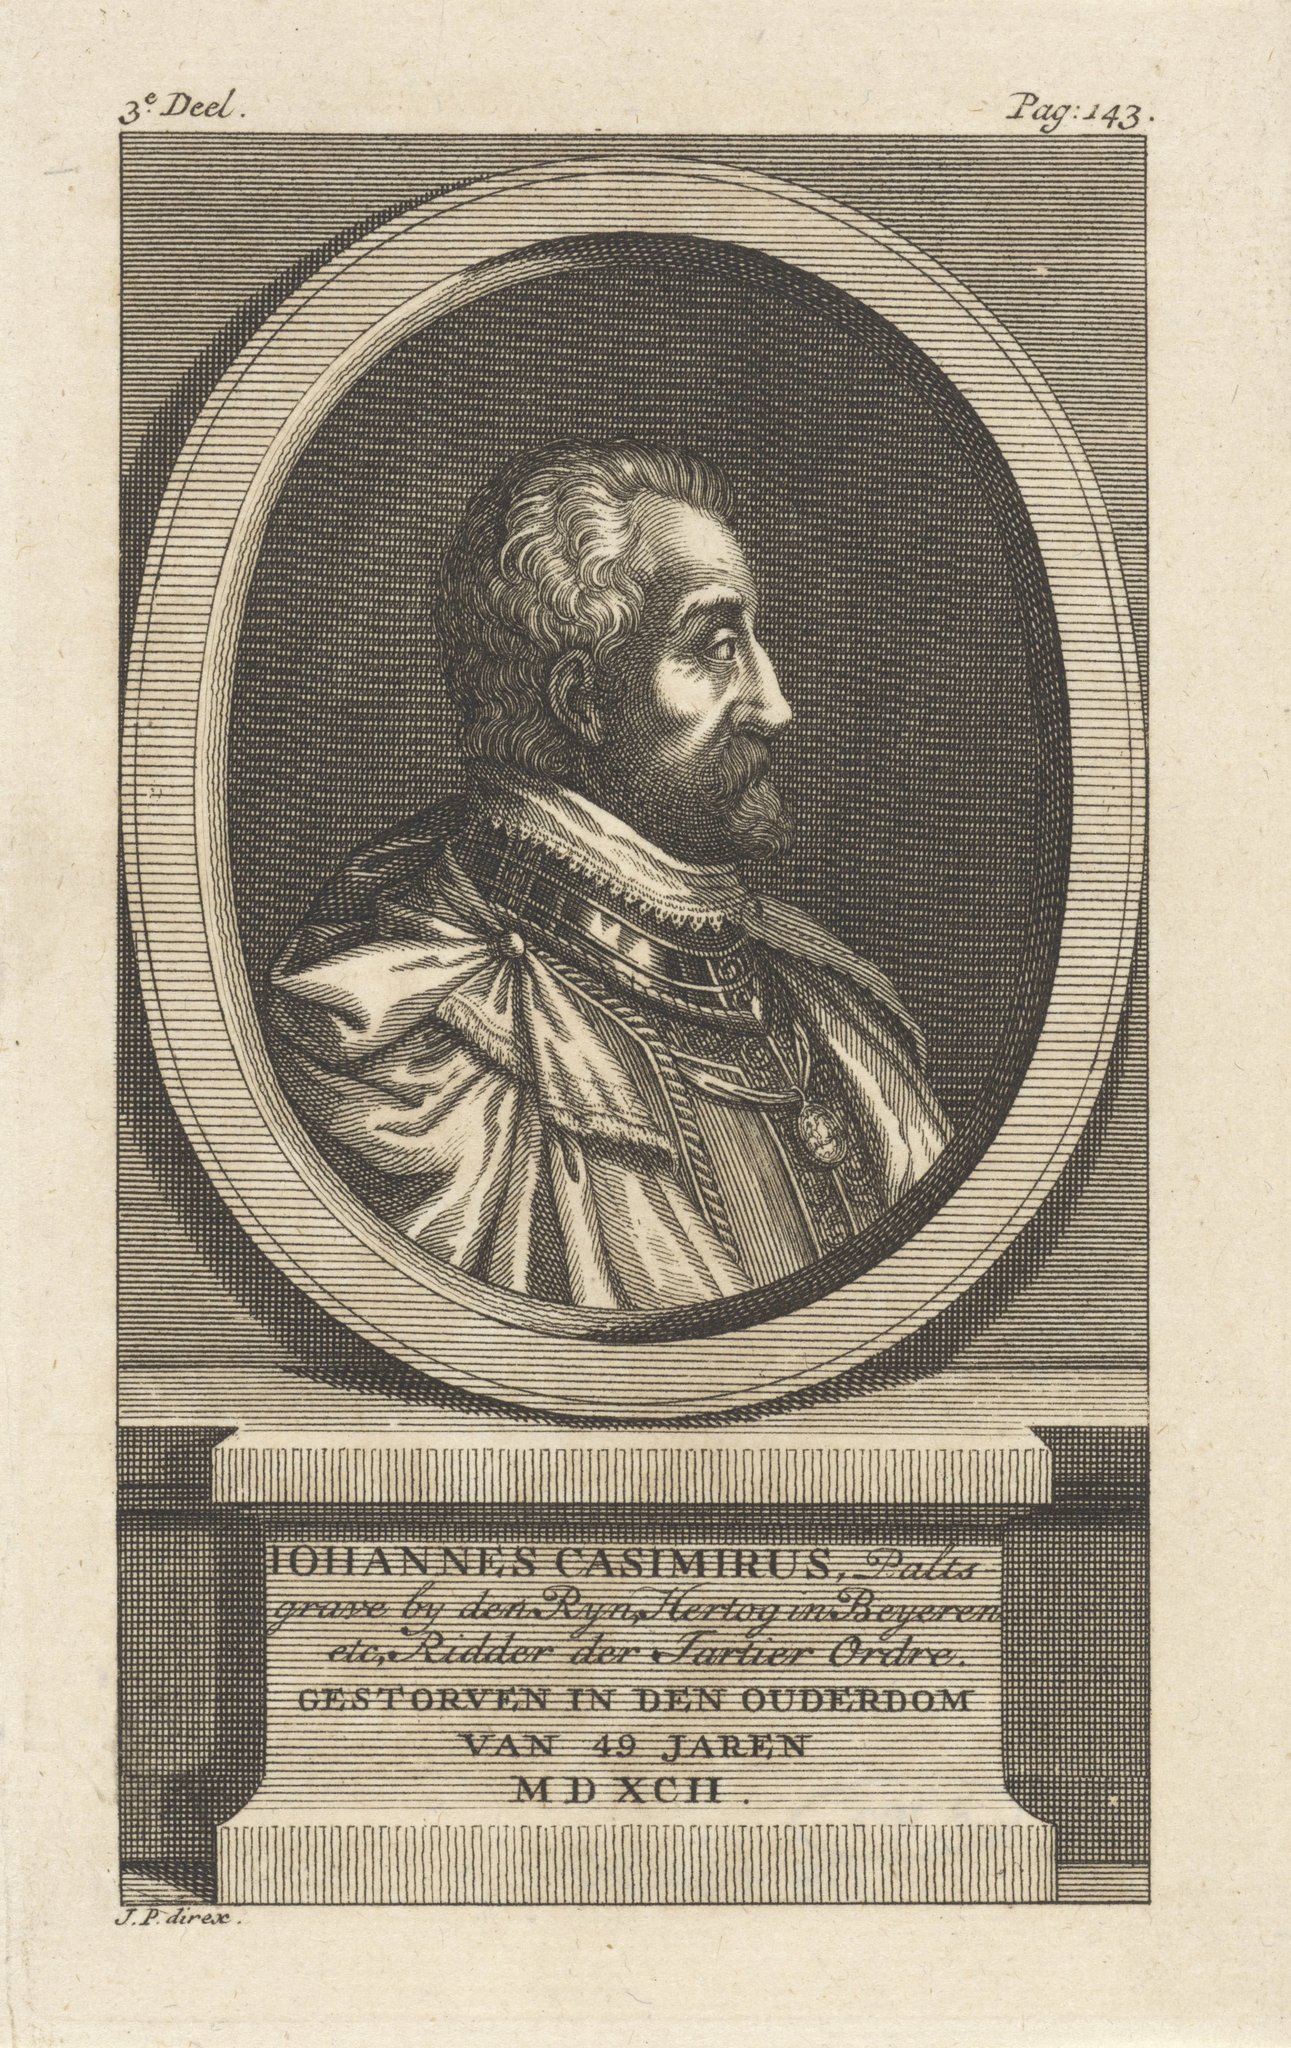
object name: print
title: Portret van Johan Casimir, paltsgraaf aan de Rijn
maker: jan punt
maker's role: draughtsman, print maker, publisher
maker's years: 1711-1779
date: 1750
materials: paper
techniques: engraving, etching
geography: northern netherlands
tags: knighthood order, armour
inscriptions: collector's mark: Lugt 2228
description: Illustratie uit: Meteren, Emanuel van. Historie van de oorlogen en geschiedenissen der Nederlanderen, en der zelver naburen: beginnende met den jare 1315, en eindigende met den jare 1611, deel III, p. 143. Gorinchem/Breda: Nicolaas Goetzee/Willem Goetzee, 1750.